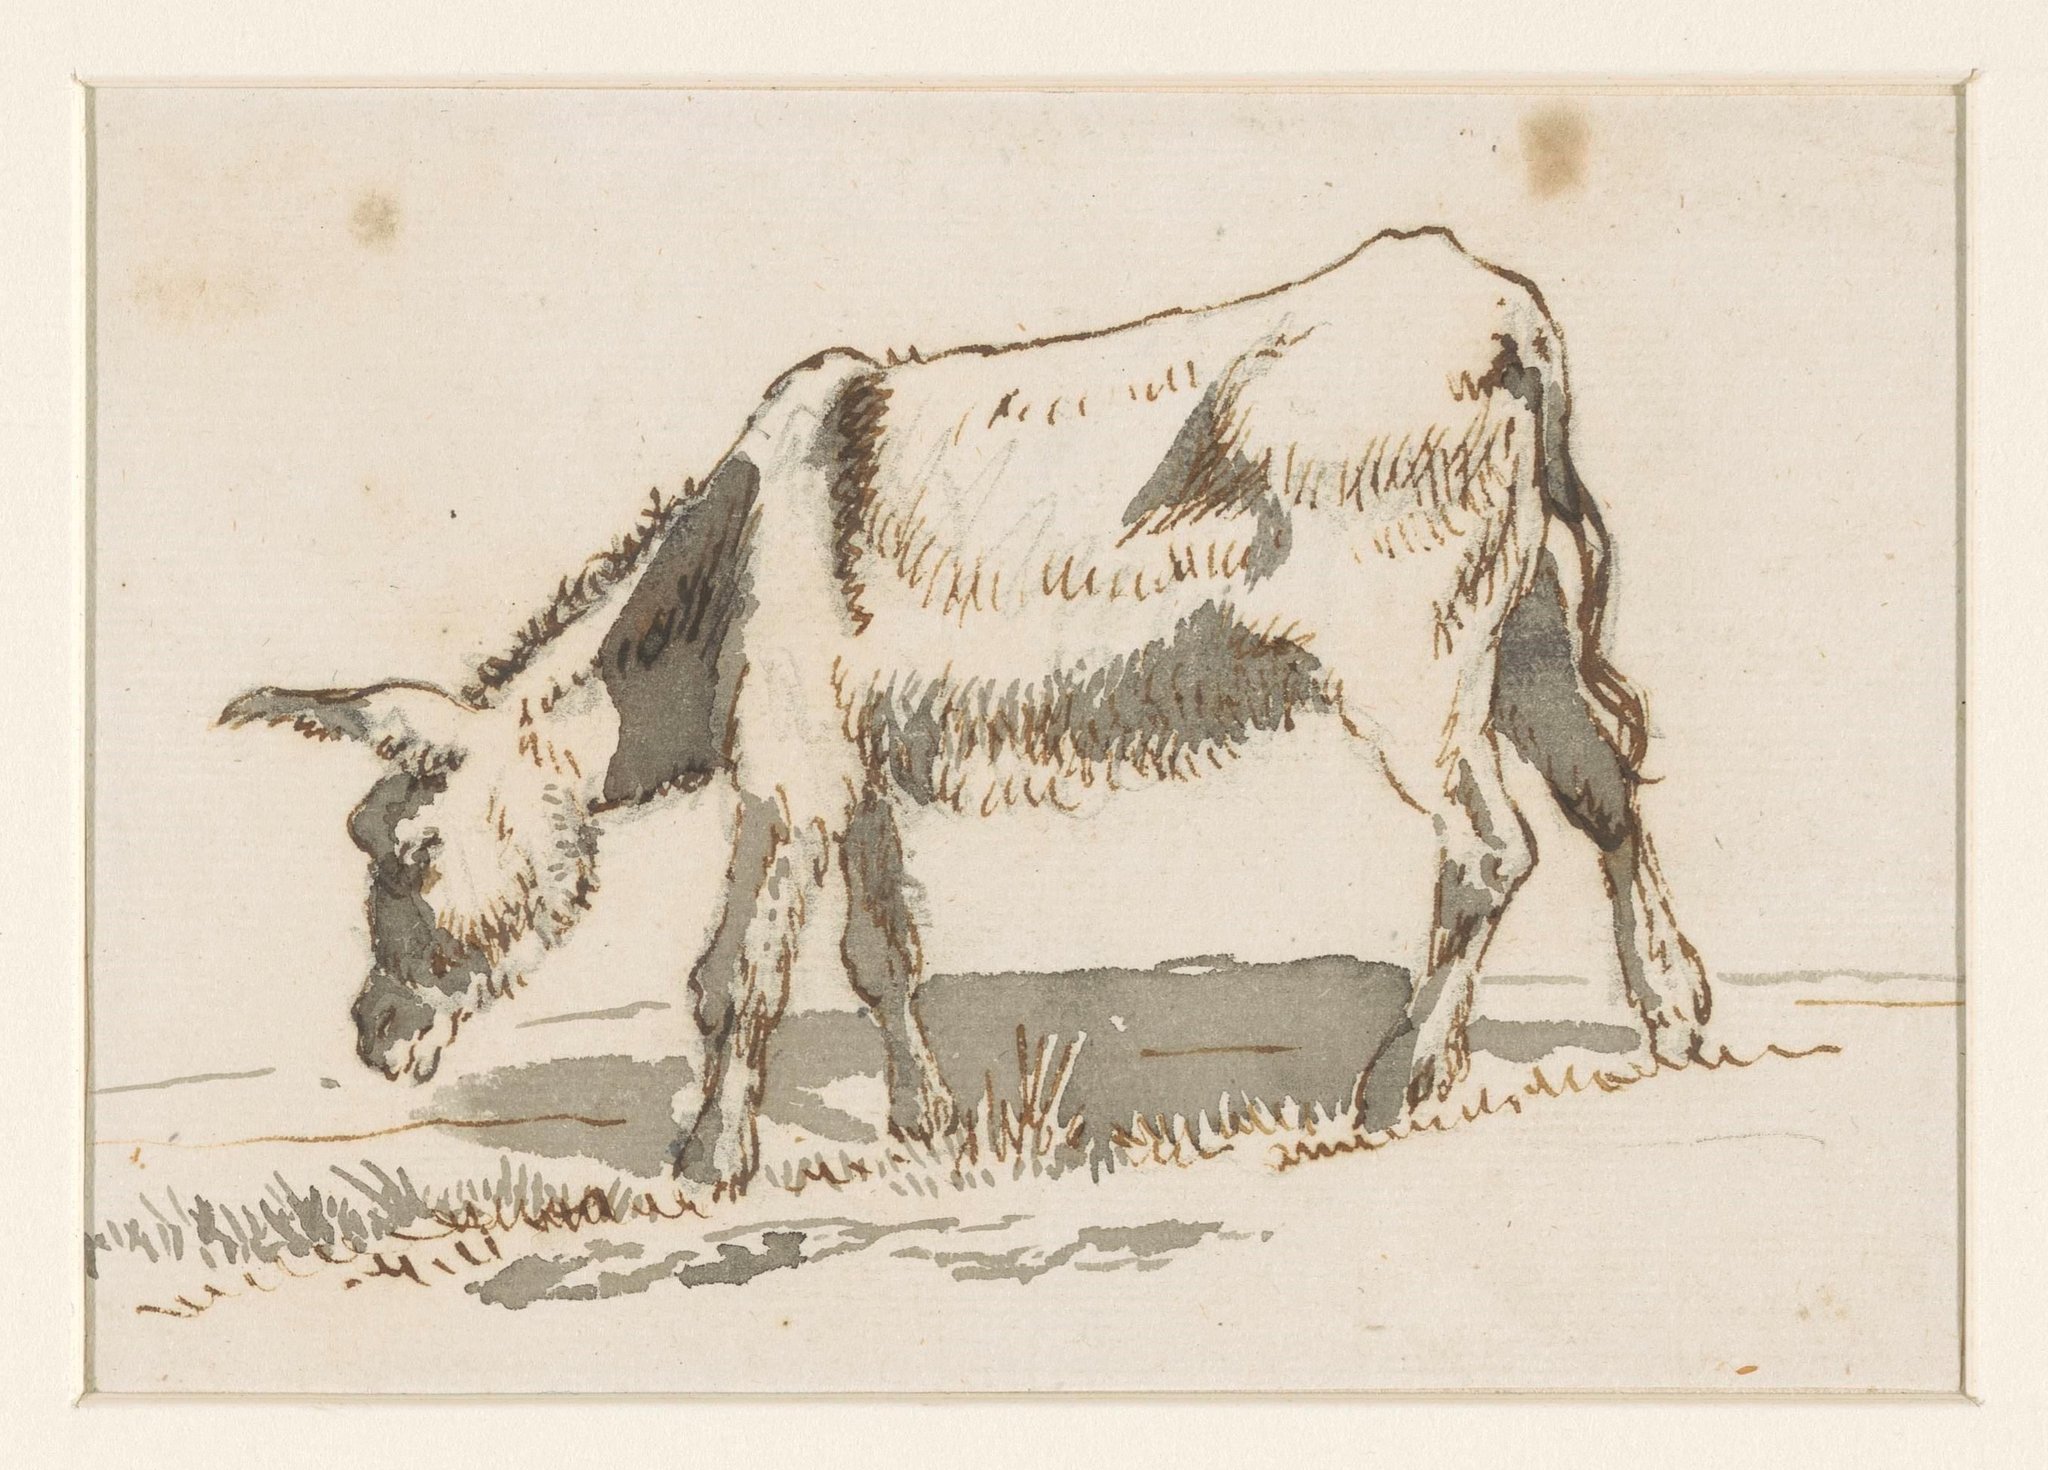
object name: drawing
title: Grazende ezel, van links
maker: david alphonse de sandoz-rollin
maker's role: draughtsman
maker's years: 1740-1809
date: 1750-1809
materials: ink, paper, pencil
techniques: brush, pen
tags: ass, donkey